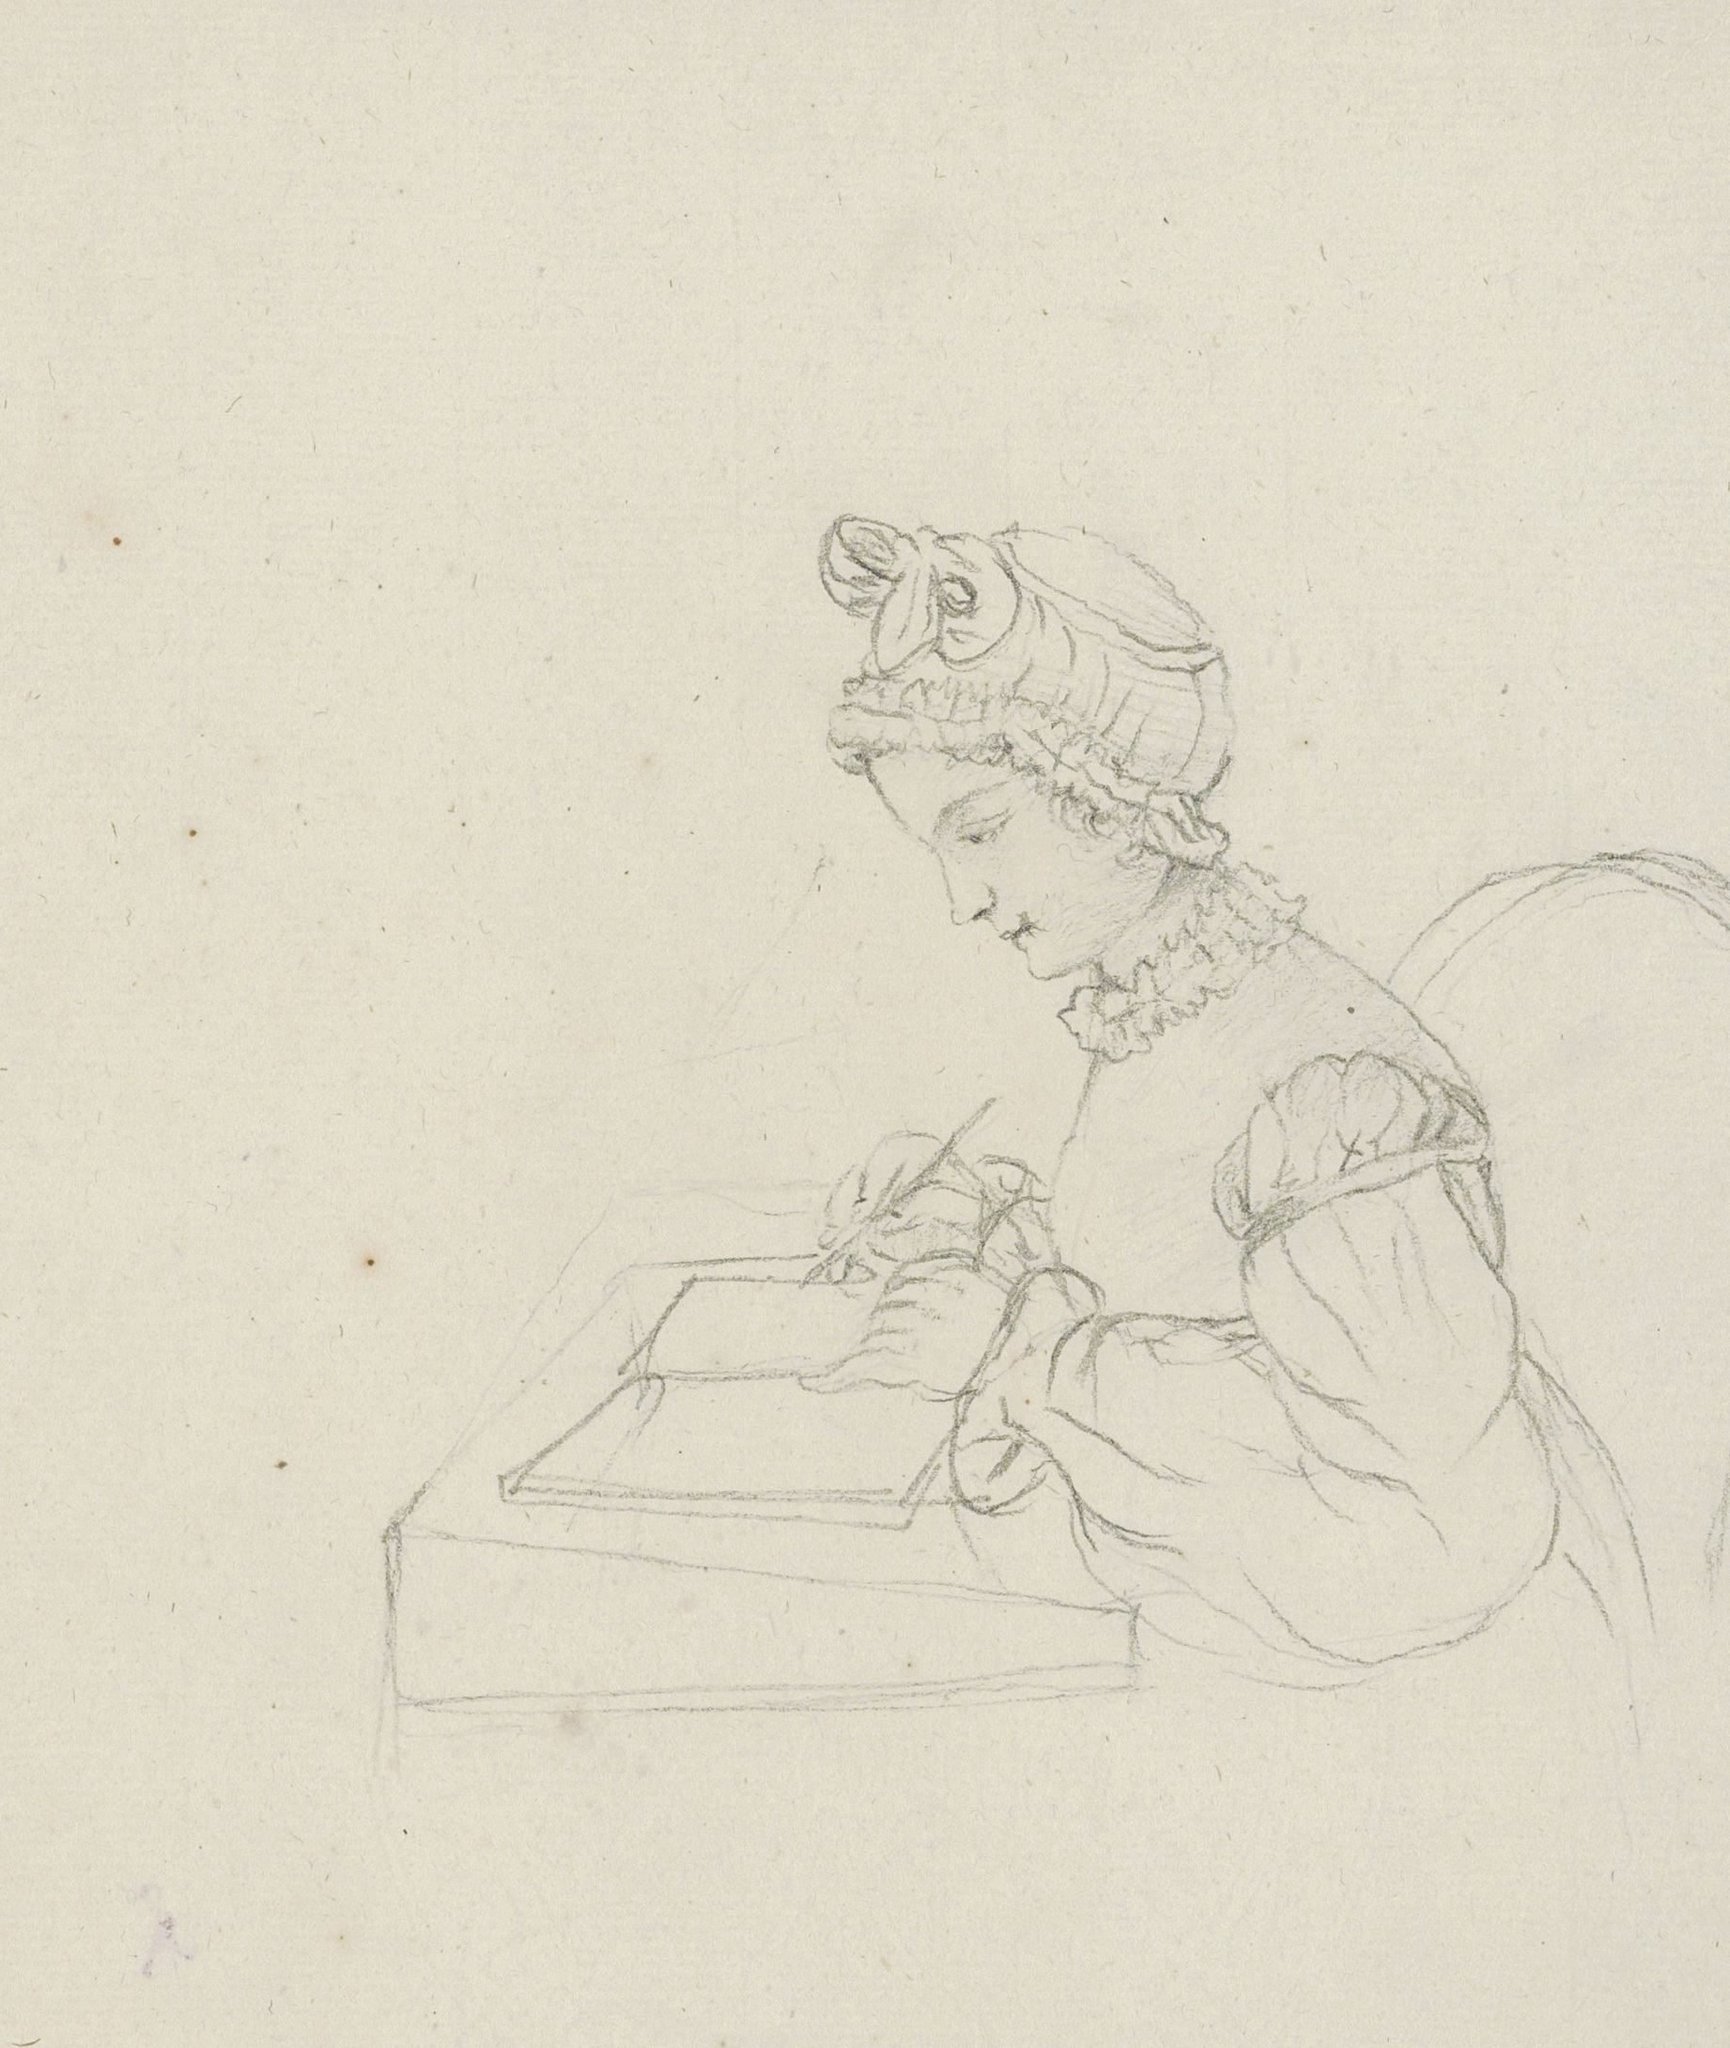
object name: sketchbook leaf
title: Catharina Kemper tekenend aan een tafel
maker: jonkvrouw elisabeth kemper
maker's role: draughtsman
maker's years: 1799-1871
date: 1815-1852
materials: paper, pencil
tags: amsterdam, draughtsman, jonkvrouw catharina kemper, drawing, historical persons (portraits and scenes from the life)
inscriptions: watermark, annotation: ‘Catharina Kemper tekenend/ (vgl. RPK 1969:16)’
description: Losse tekening tussen blad 94 en het achterste schutblad uit een schetsboek met 94 bladen.